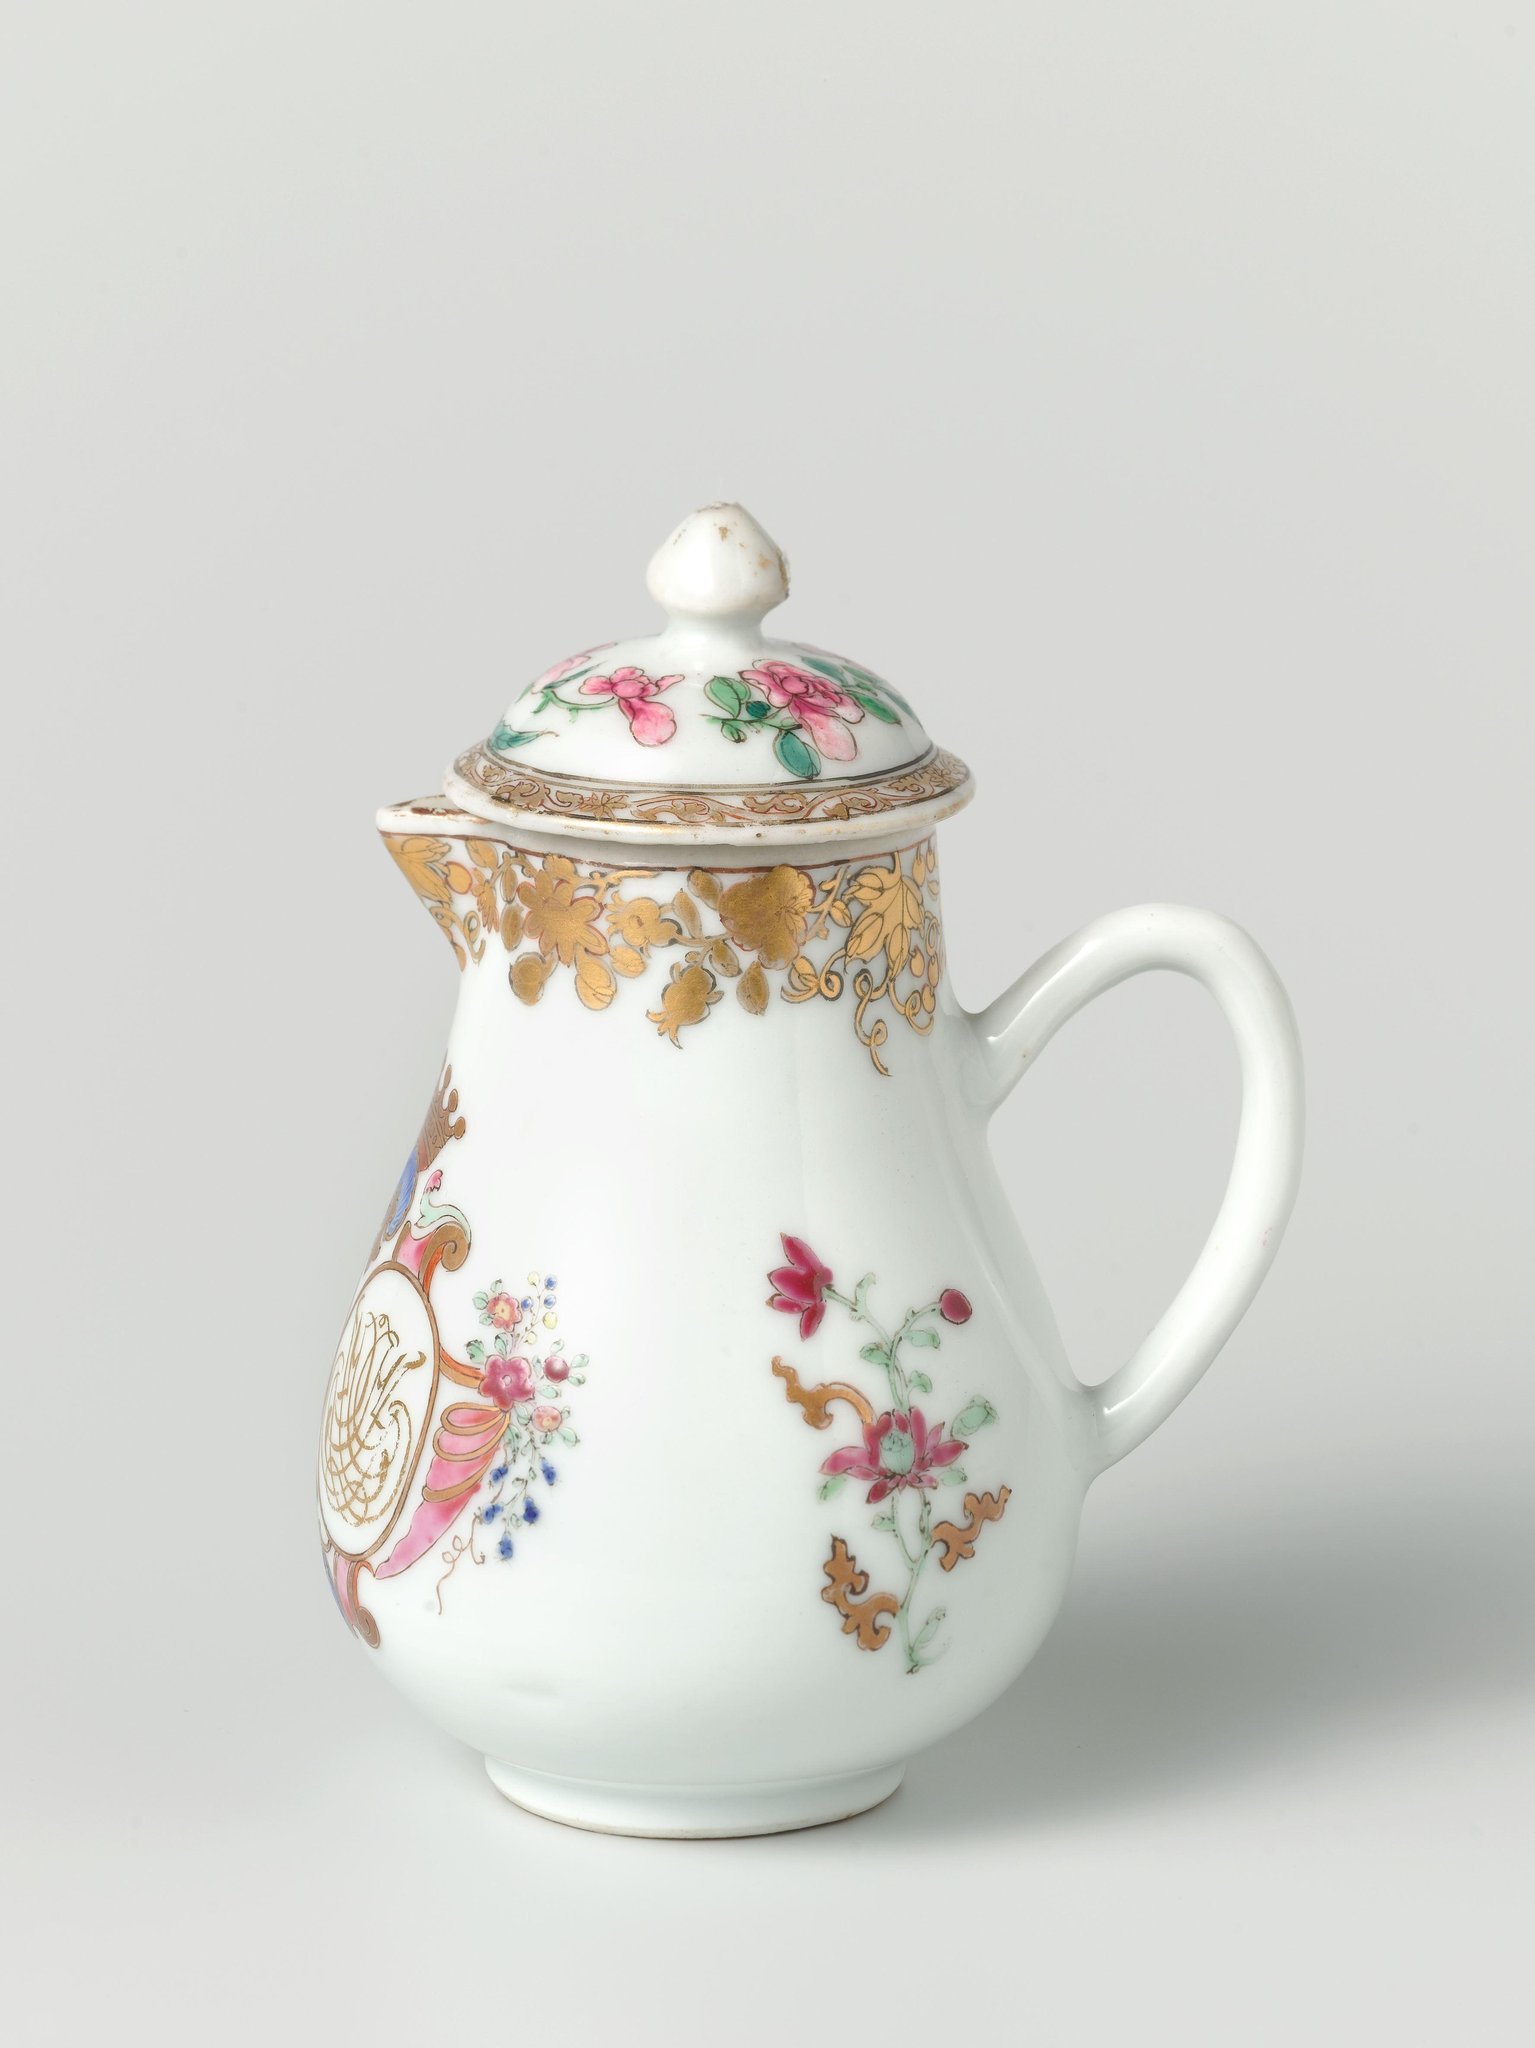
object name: milk jug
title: Pear-shaped milk jug with handle from the 'Swellengrebel service' with a double crowned monogram and a border with floral scrolls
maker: Anonymous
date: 1740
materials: glaze, gold, paint, porcelain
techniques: firing, gilding, turning, vitrification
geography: china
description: Melkkan op een voet, met een peervormig lichaam, een kleine bek en een C-vormig oor. De (niet bijpassende) deksel heeft een puntige dekselknop. Onder de bek een dubbel spiegelmonogram met terweerszijden kleine bloeiende lotusranken. Rond de bovenrand bloeiende ranken in goud. Op de deksel twee bloeiende lotusranken omgeven door een smalle band met gestileerde gouden ranken.